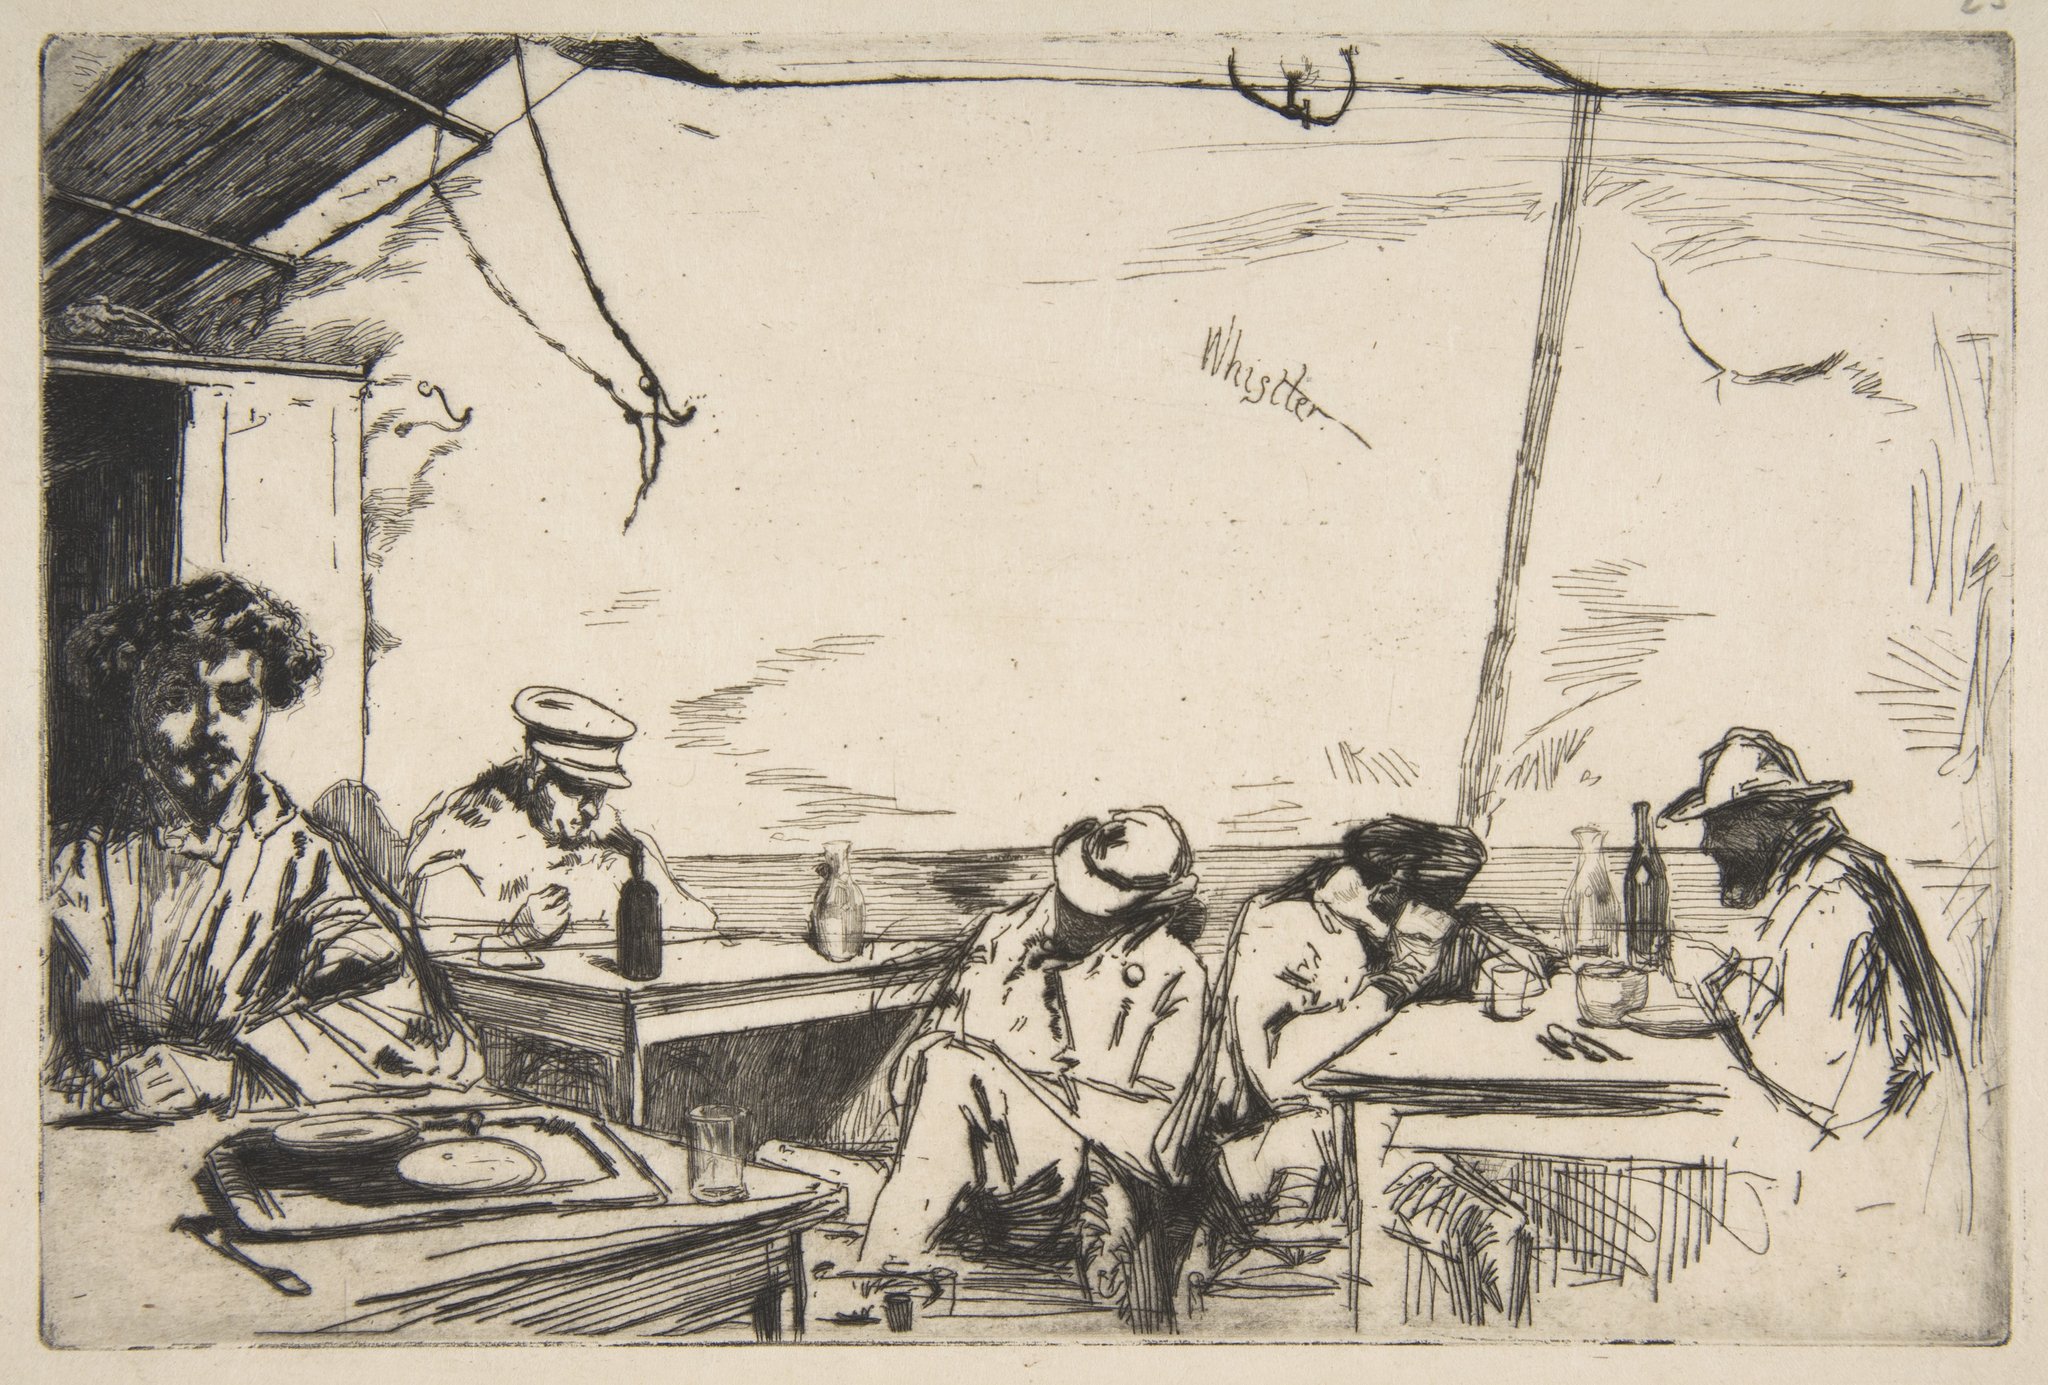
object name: print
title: Soupe à trois sous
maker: james mcneill whistler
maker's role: artist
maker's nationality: american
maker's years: 1834-1903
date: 1859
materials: ink, paper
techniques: etching, printing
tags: sleeping,men,tables,cafe